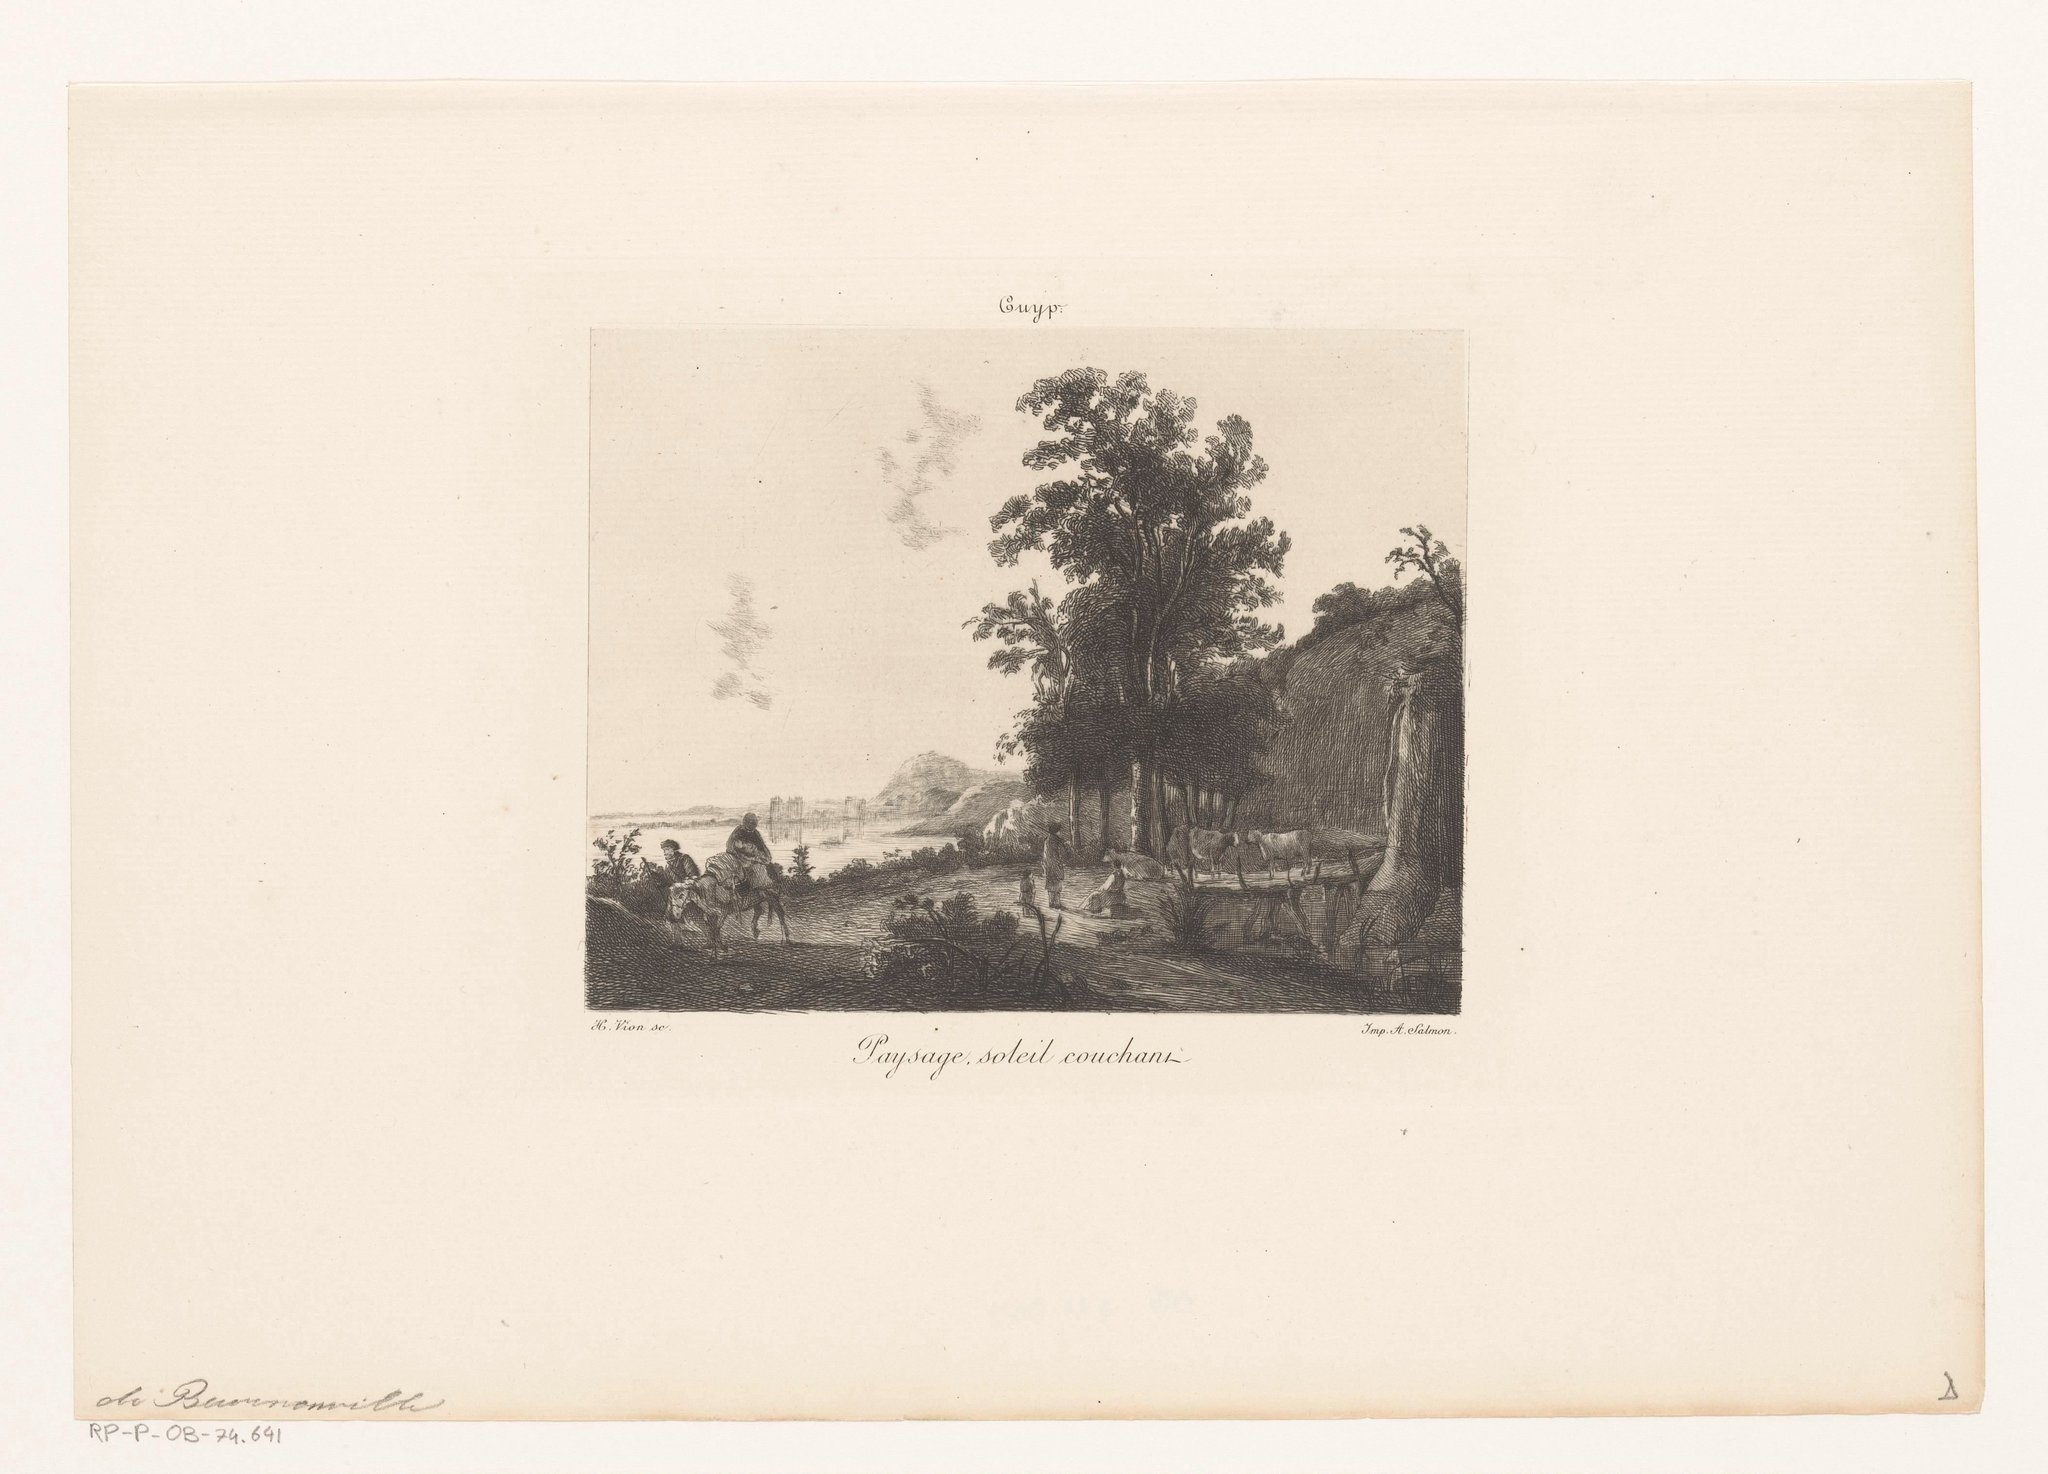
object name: print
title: Rivierlandschap met reizigers en veehoeders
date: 1873-1894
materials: paper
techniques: etching, intaglio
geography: paris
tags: herding, herdsman, herdswoman, shepherd, shepherdess, cowherd, etc., 'en route', traveller under way, landscapes with waters, waterscapes, seascapes (in the temperate zone) - hh - ideal landscapes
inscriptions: collector's mark: Lugt 2228